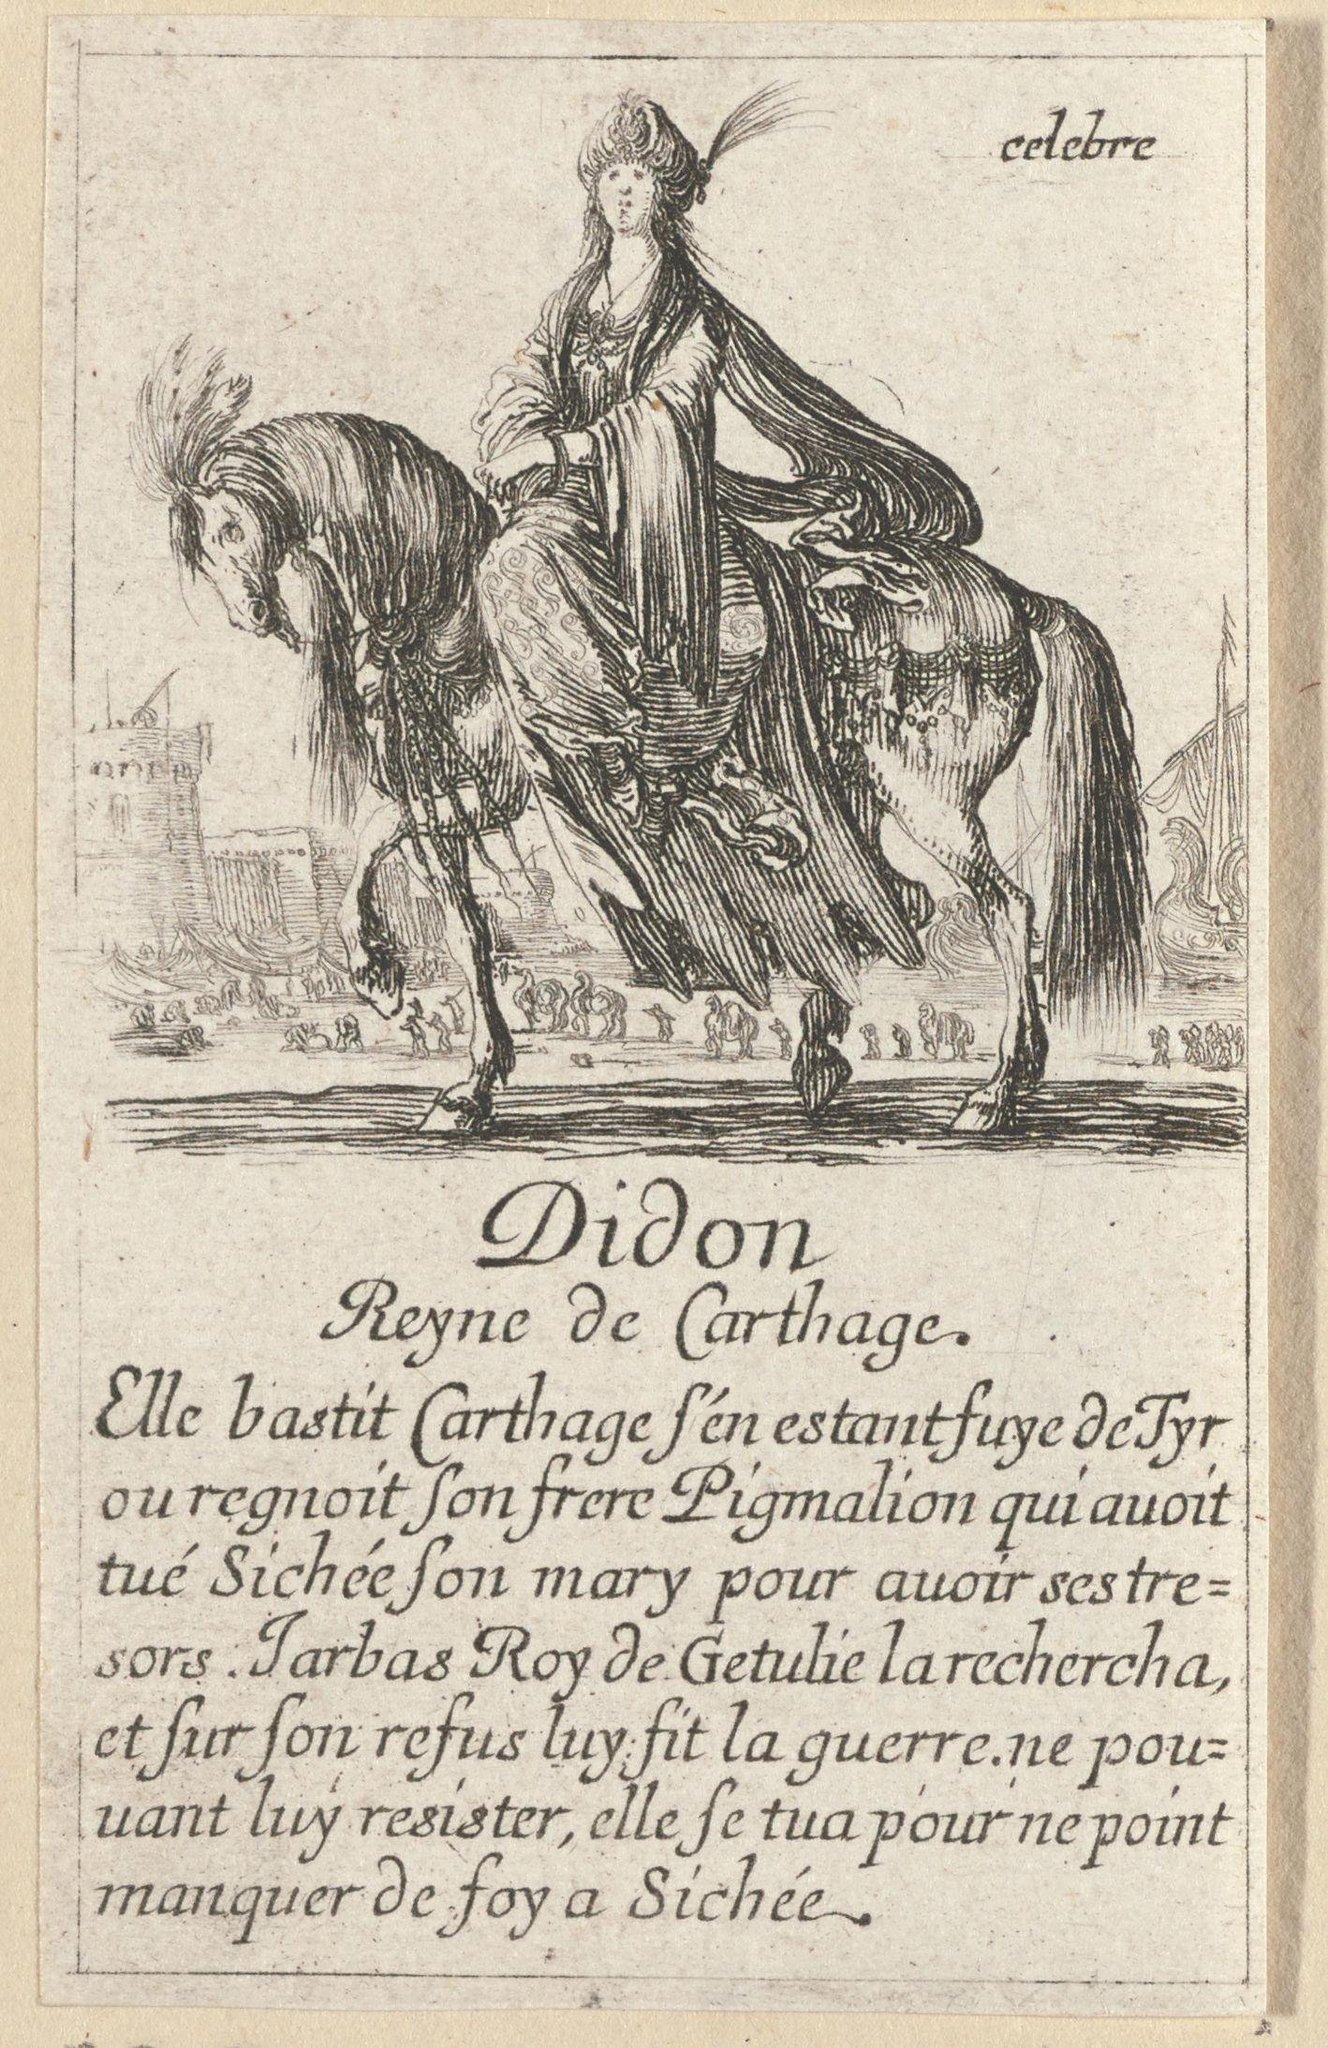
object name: playing card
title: Didon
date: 1620-1664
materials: paper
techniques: etching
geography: paris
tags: (story of) dido, ruler, sovereign - bb - female ruler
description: Deze prent maakt deel uit van een kaartspel met 52 kaarten met voorstellingen van beroemde koninginnen. De serie is uitgedacht door Jean Desmarests de Saint-Sorlin in opdracht van Kardinaal Mazarin. Het kaartspel werd gemaakt voor de jonge Lodewijk XIV, samen met het Jeu des Fables, Jeu de la Géographie en Jeu des Rois de France.